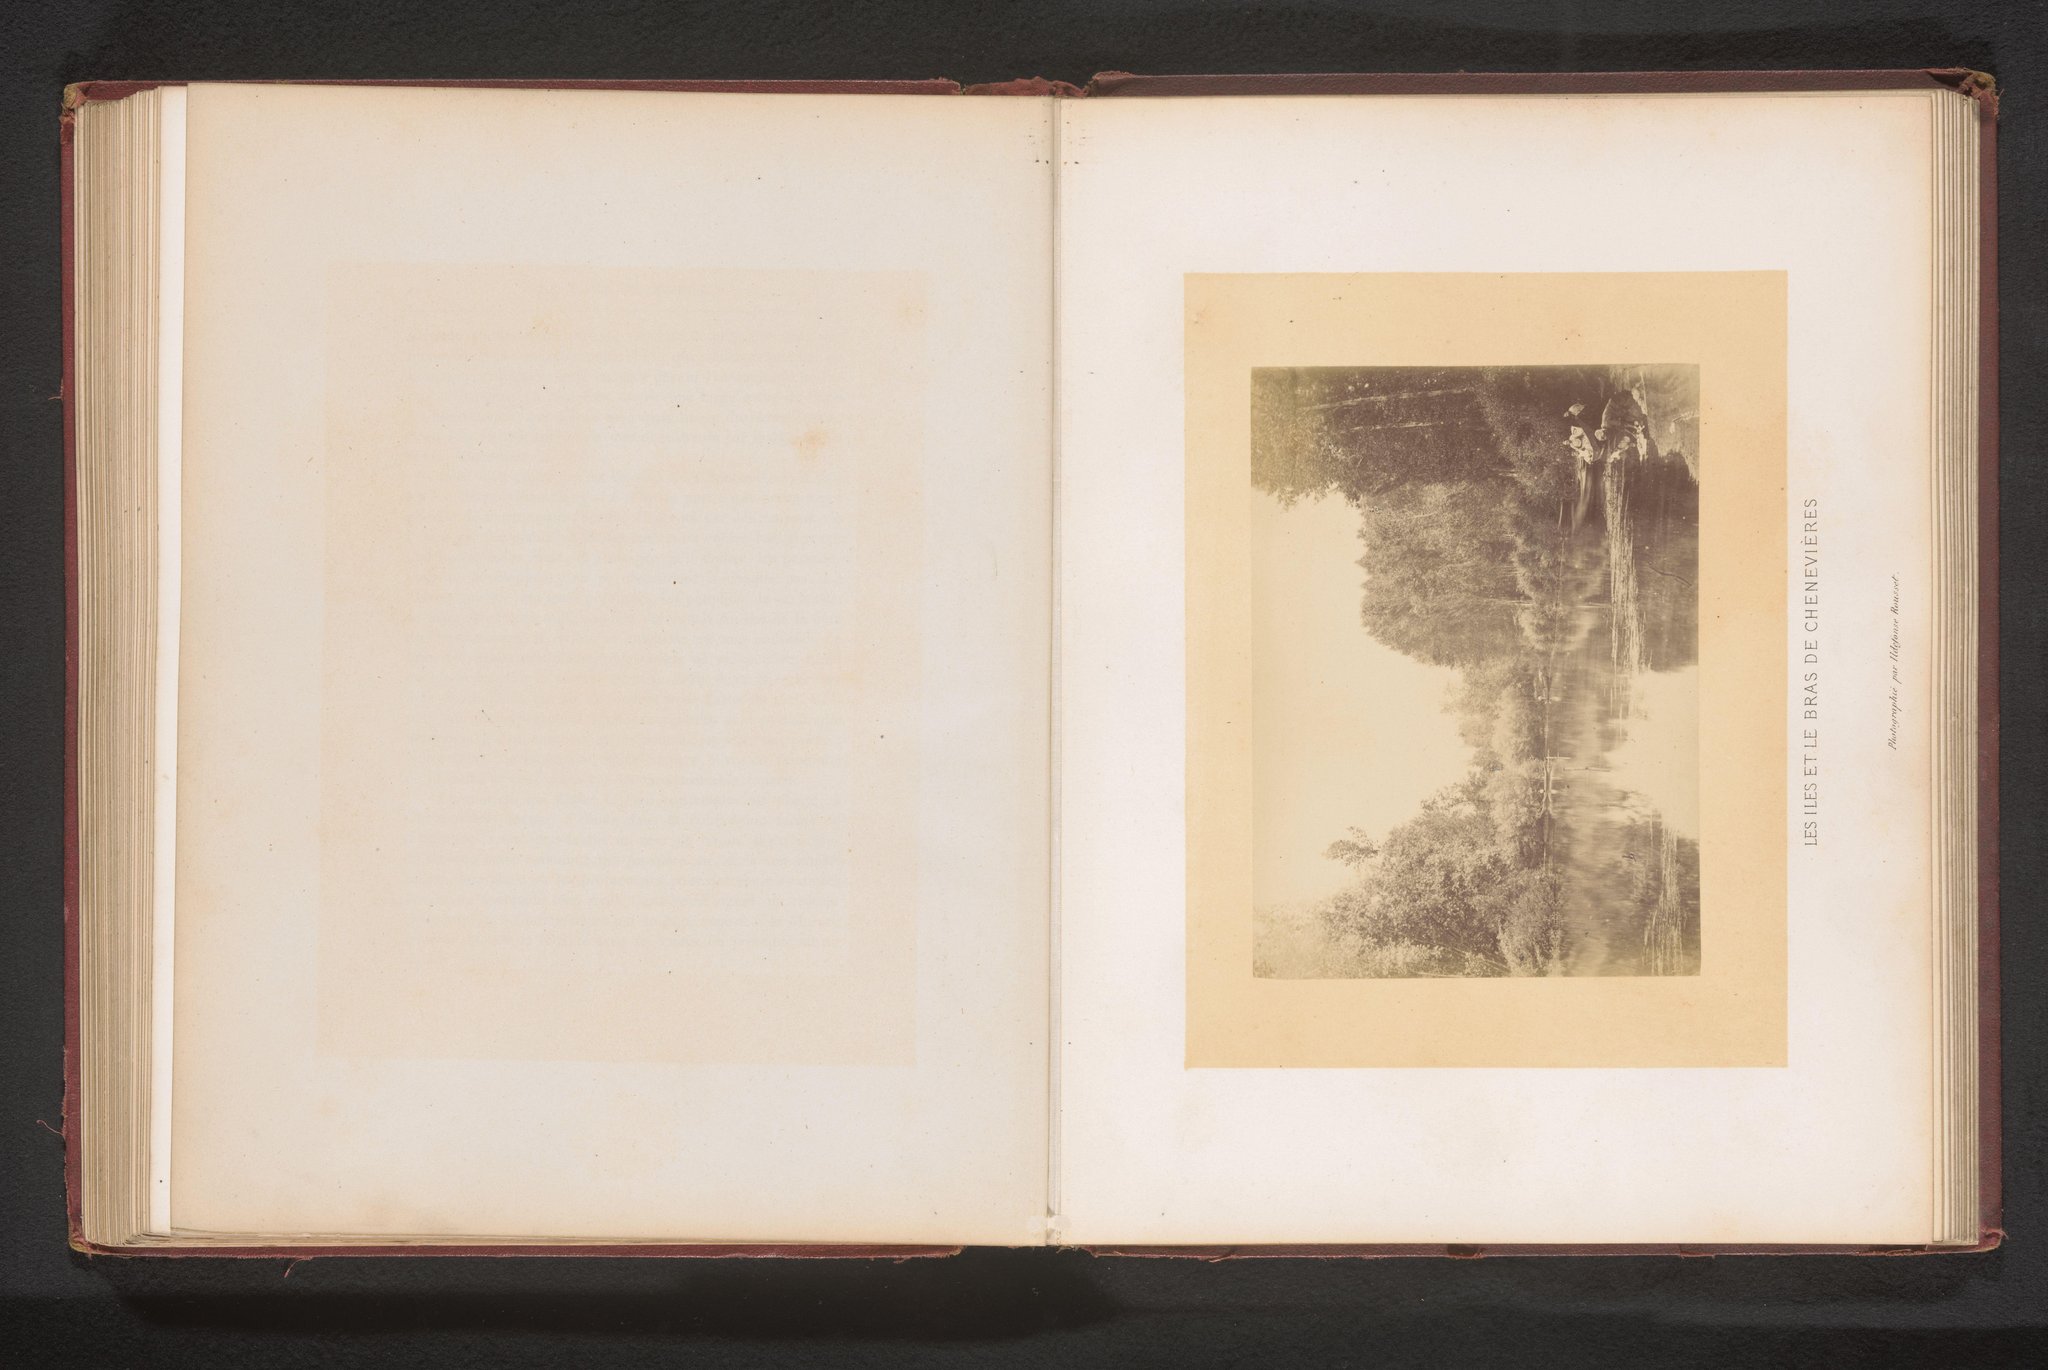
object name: page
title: Eilanden in de Marne te Chennevières-sur-Marne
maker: ildefonse rousset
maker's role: fotograaf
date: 1860-1865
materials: photographic support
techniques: albumen print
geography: chennevières-sur-marne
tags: island, river